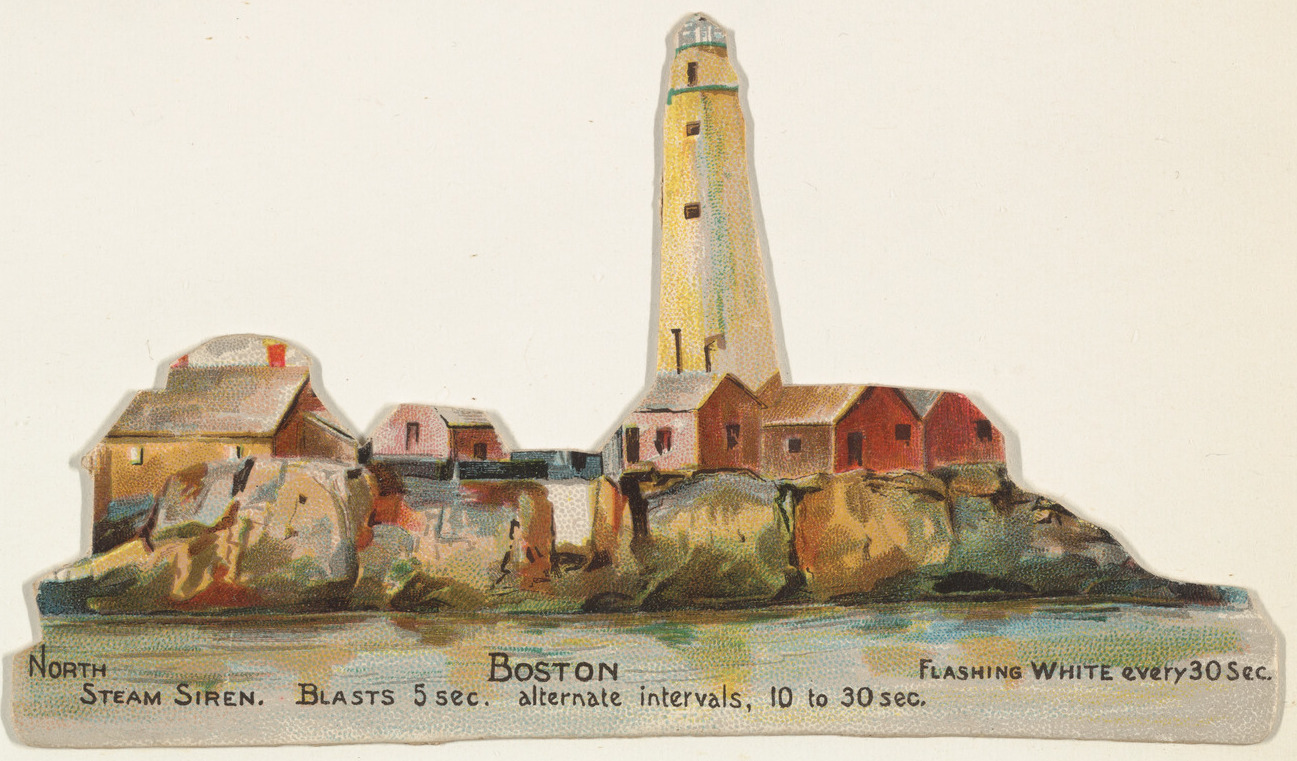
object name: print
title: Boston, from the Lighthouses series (N119) issued by Duke Sons & Co. to promote Honest Long Cut Tobacco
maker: w. duke, sons & co.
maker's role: publisher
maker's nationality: american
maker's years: 1870-1920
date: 1889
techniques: color lithograph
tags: lighthouses